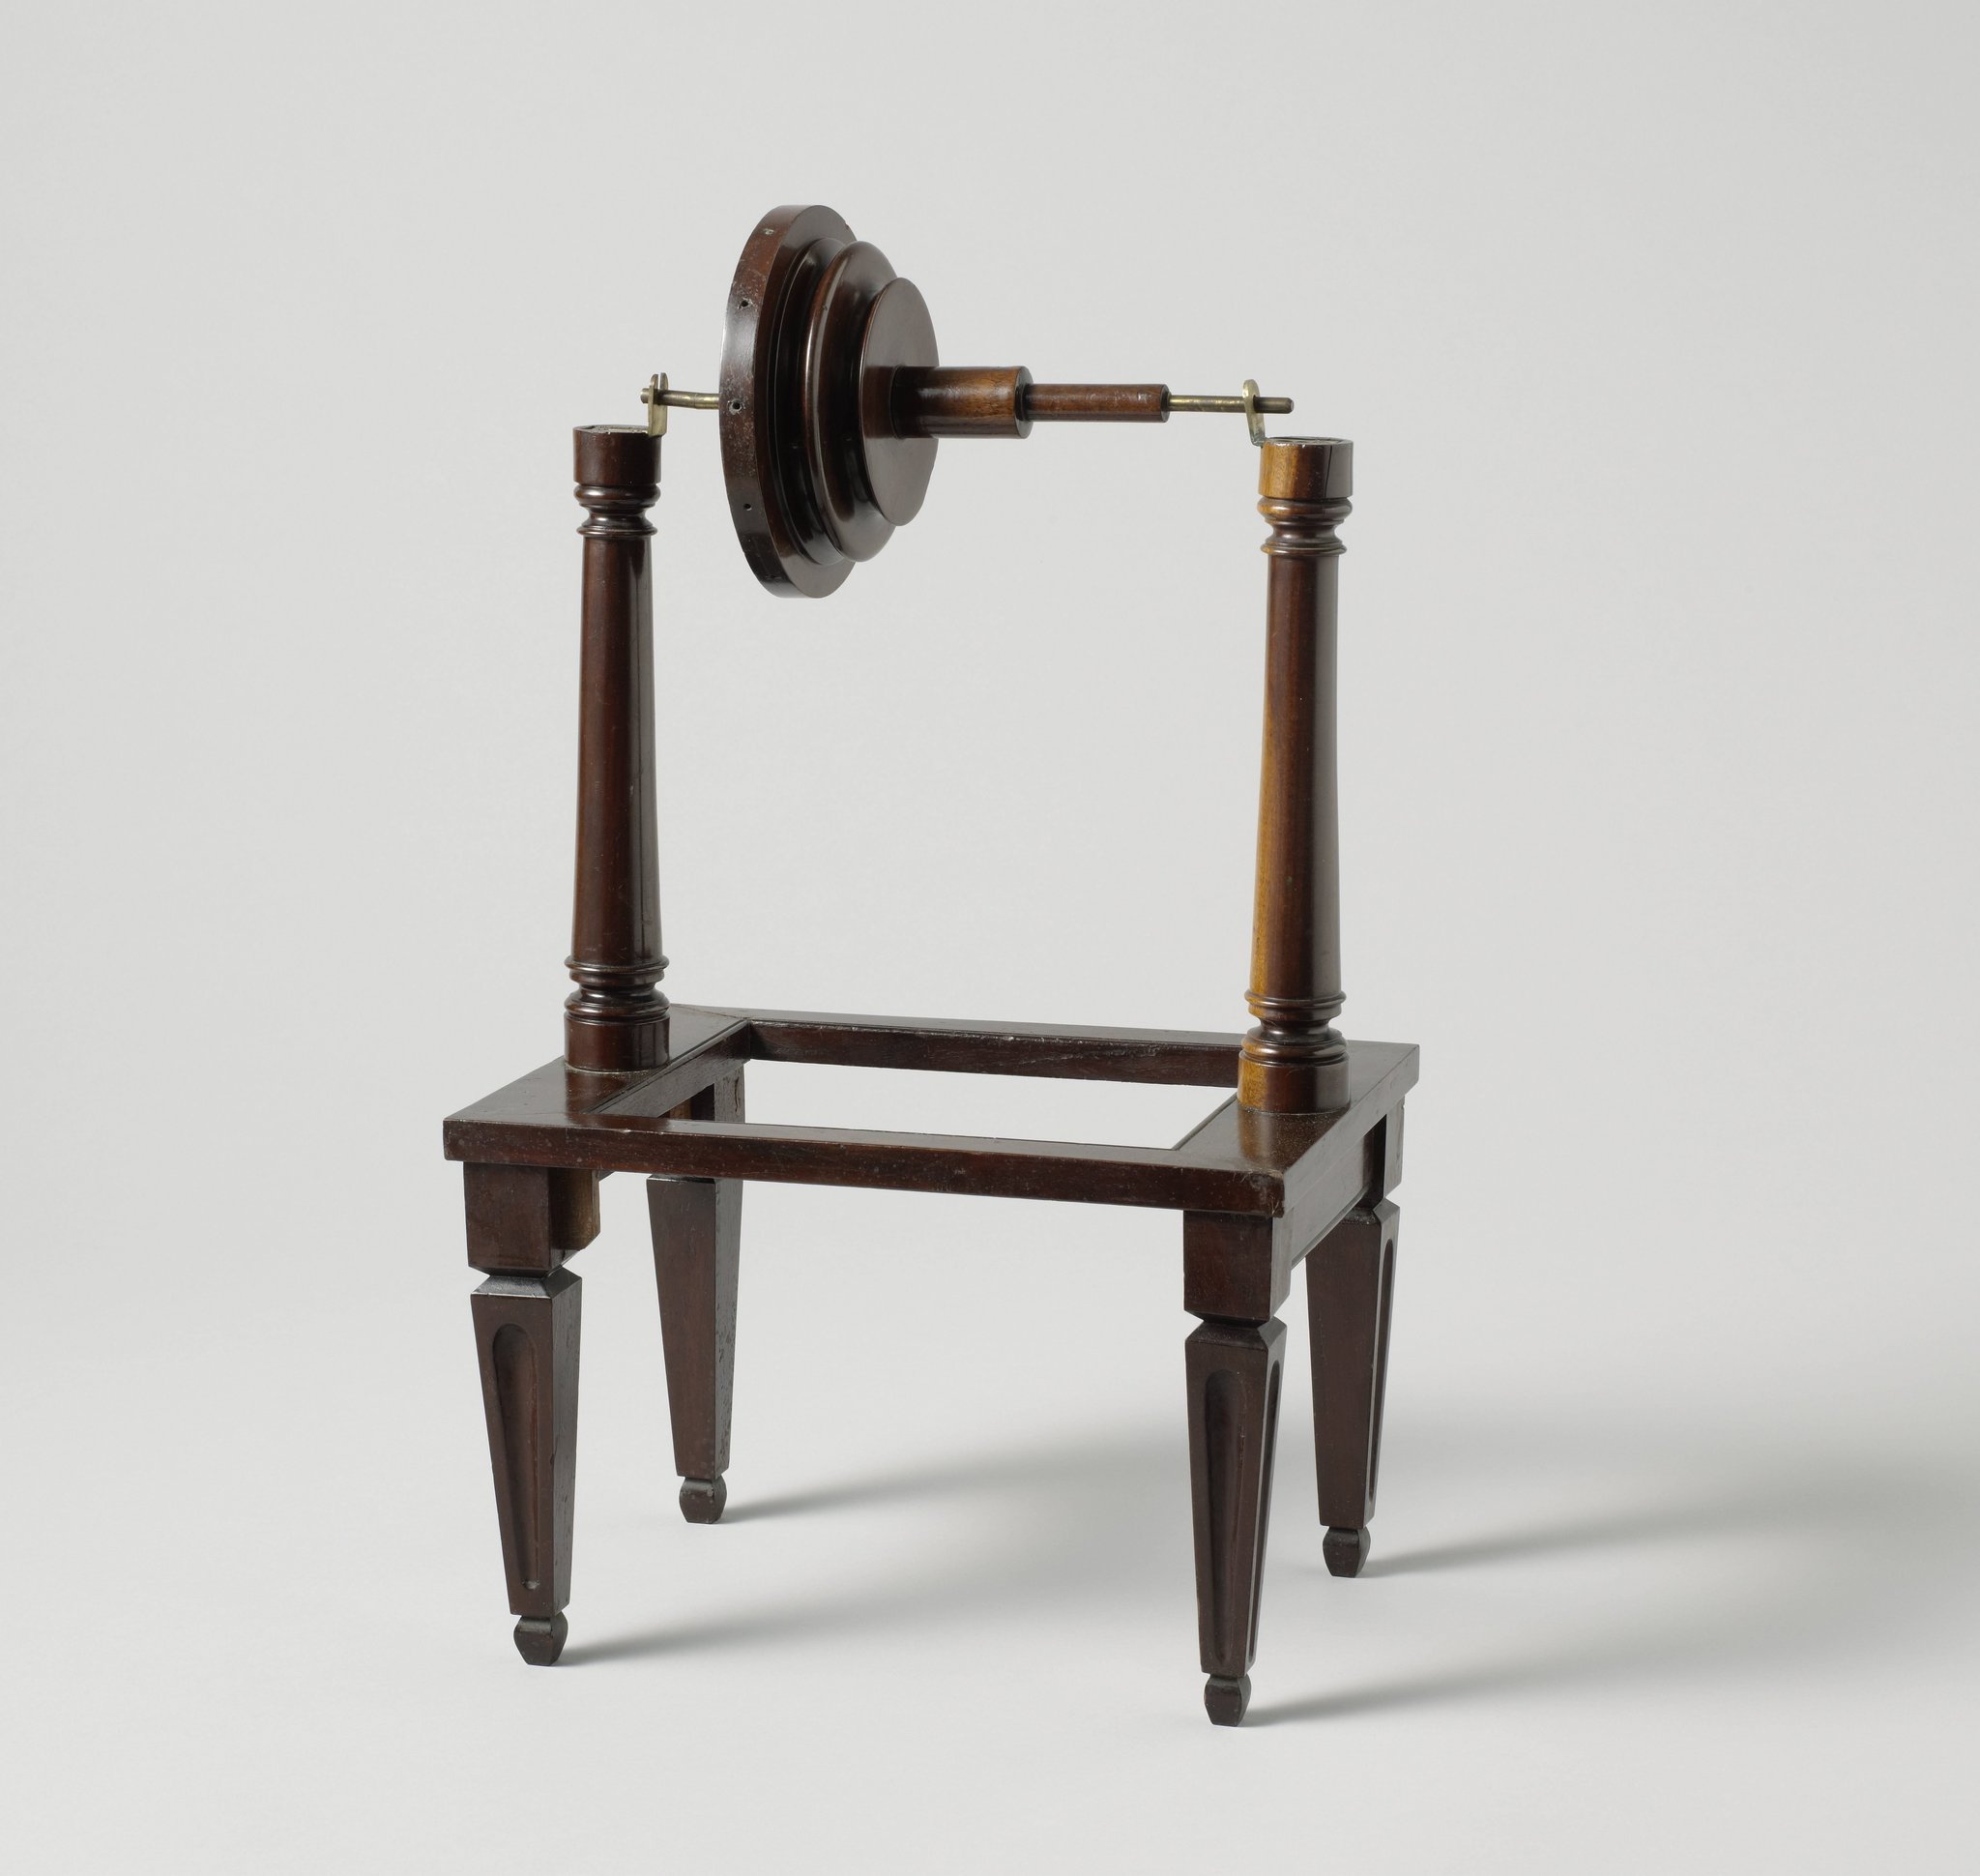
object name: demonstration model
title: Compound Wheel and Axle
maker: Anonymous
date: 1750-1800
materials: brass, wood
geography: netherlands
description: Model van een windas, incompleet. Het staat op een klein tafelvormig voetstuk en bestaat uit een as met dubbele schijf, op twee palen. De schijf heeft twee groeven van verschillende diameter, waarin vaste ogen voor het takel zijn aangebracht. De rest van het model ontbreekt.